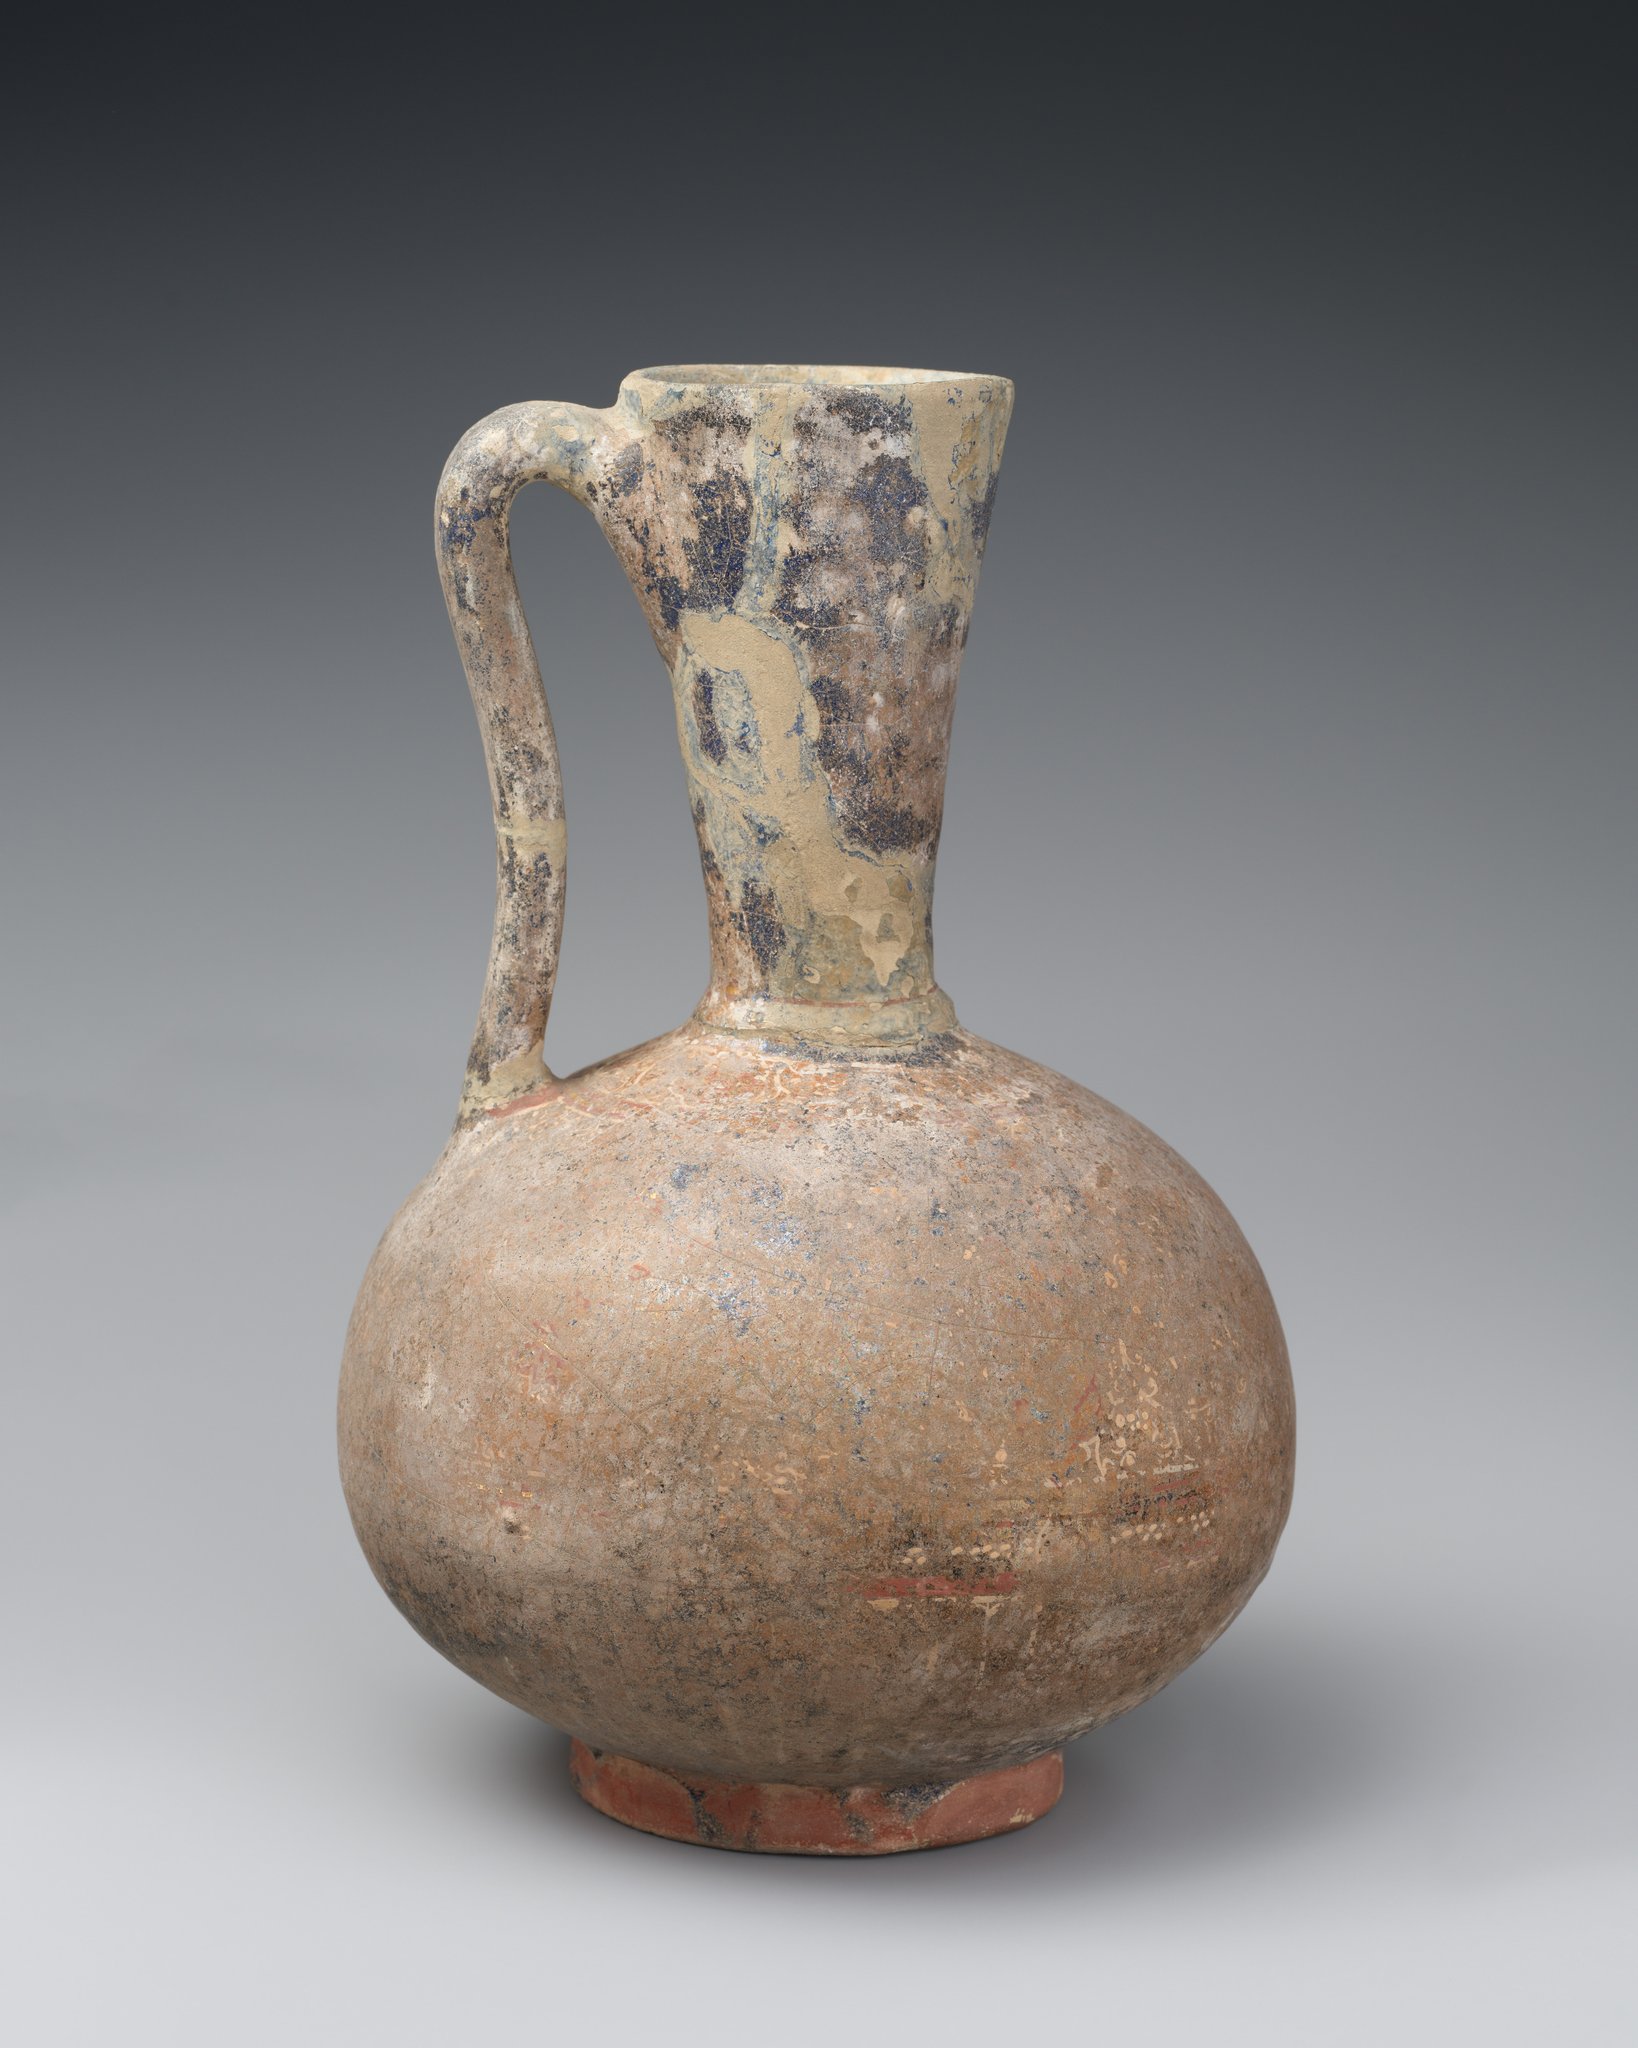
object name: ewer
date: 1301-1400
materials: ceramic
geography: iran